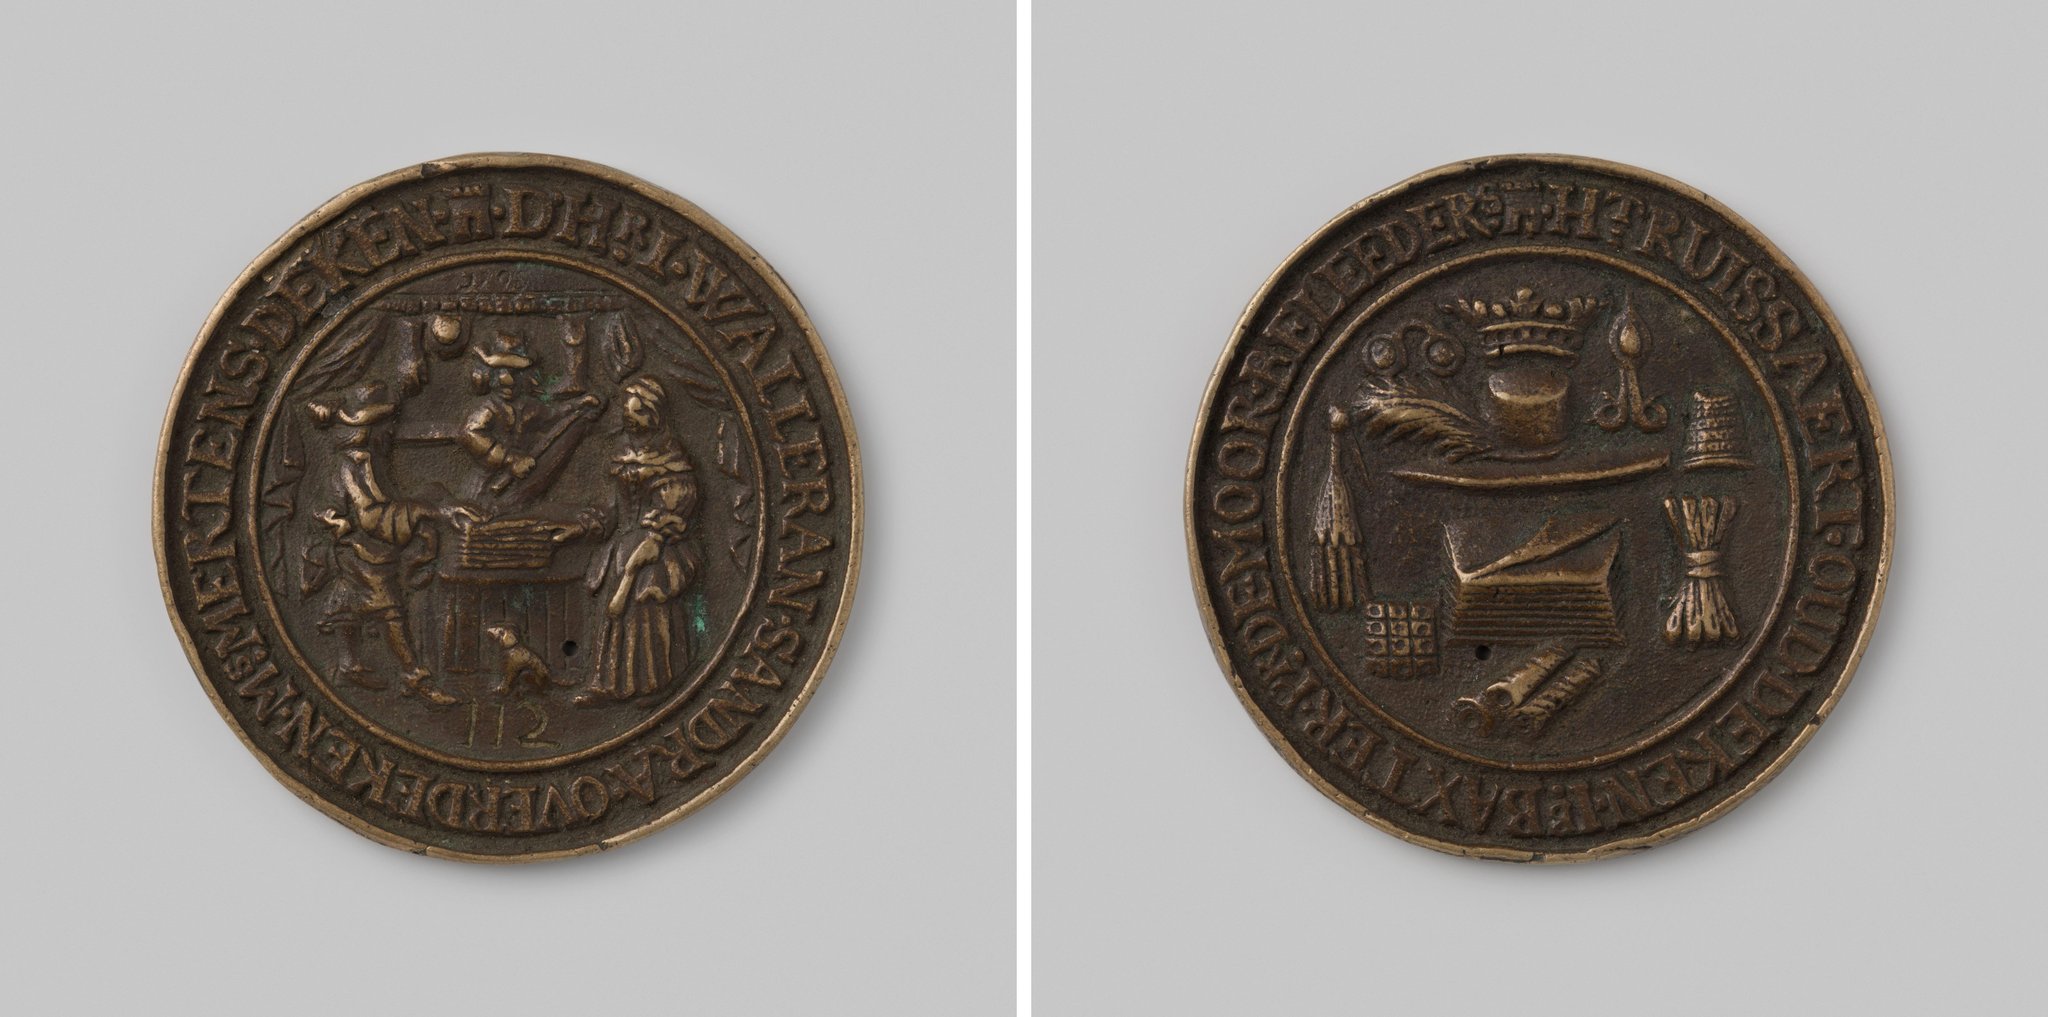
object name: history medal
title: Presentiepenning van het Zijdelakerkopers en Kramersgilde te Middelburg, 1705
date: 1705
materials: brass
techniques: casting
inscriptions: circumscription: ‘(burcht) D HR I WALLERAN SANDRA OVERDEKEN MS MERTENS DEKEN’, inscription: ‘112’, circumscription: ‘(burcht) HT RUISSAERT OUD DEKEN IB BAXTER PR DE MOOR BELEEDERS’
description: Gegoten messing penning, op de voorzijde het interieur van een lakenwinkel, bovenaan 1705, onderaan gegraveerd het getal 112, met omschrift, op de keerzijde kramerswaren: gekroonde hoed met pluim, bril, kwast, kam, vingerhoed, kaart knopen, etc. met omschrift, met klein gaatje